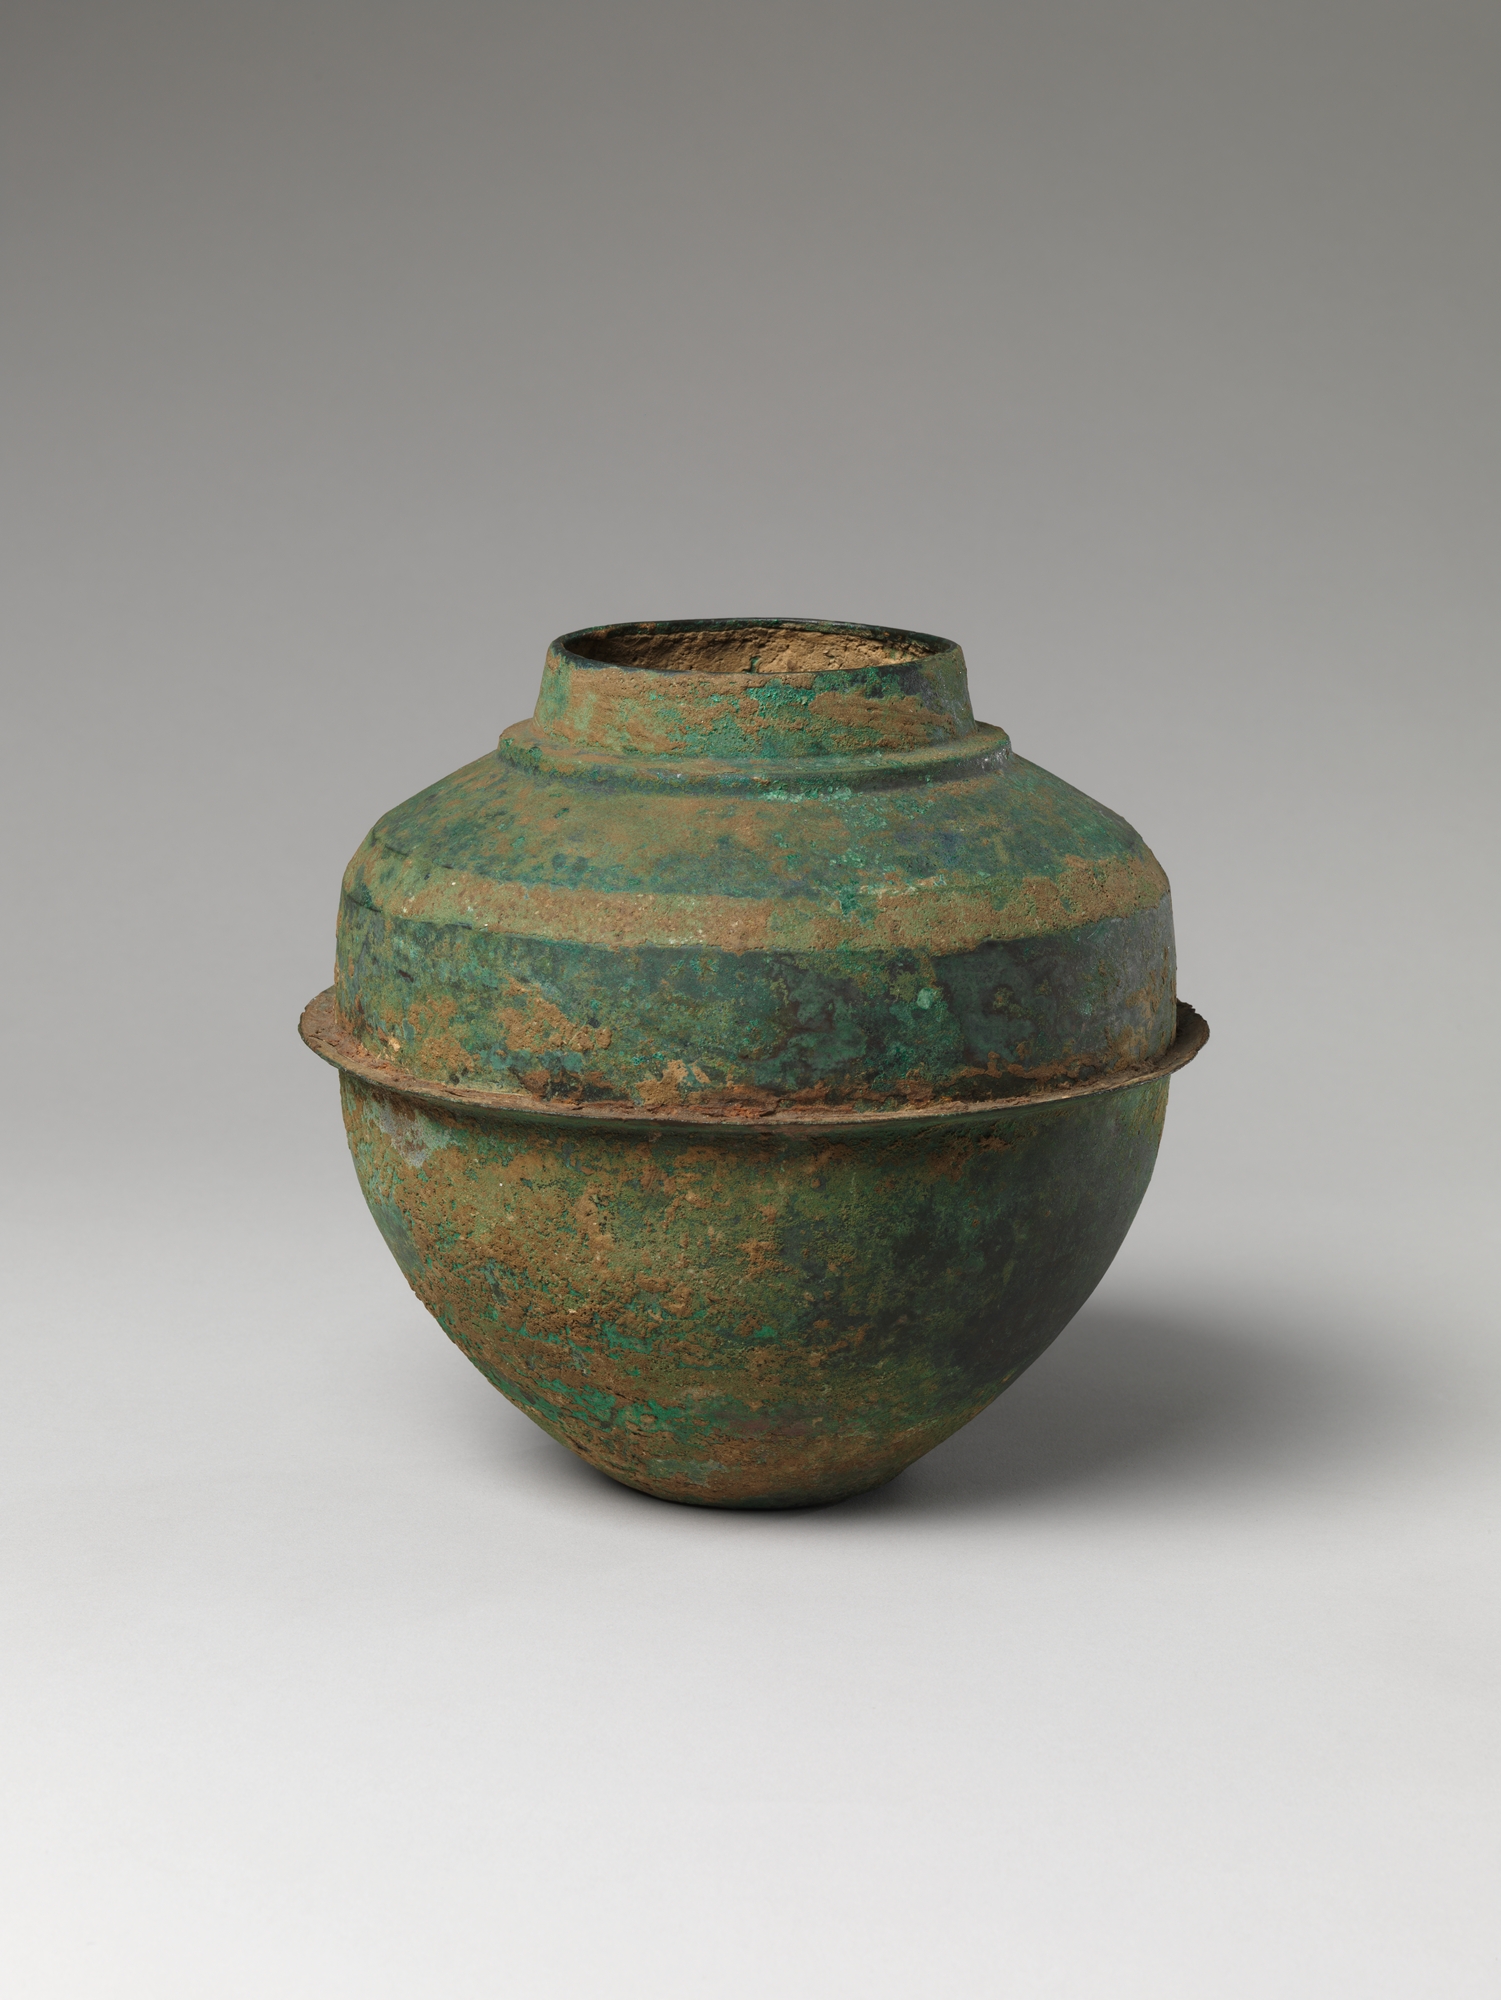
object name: cooking vessel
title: Cooking Vessel (Xian)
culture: chinese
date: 770-256 BCE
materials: bronze